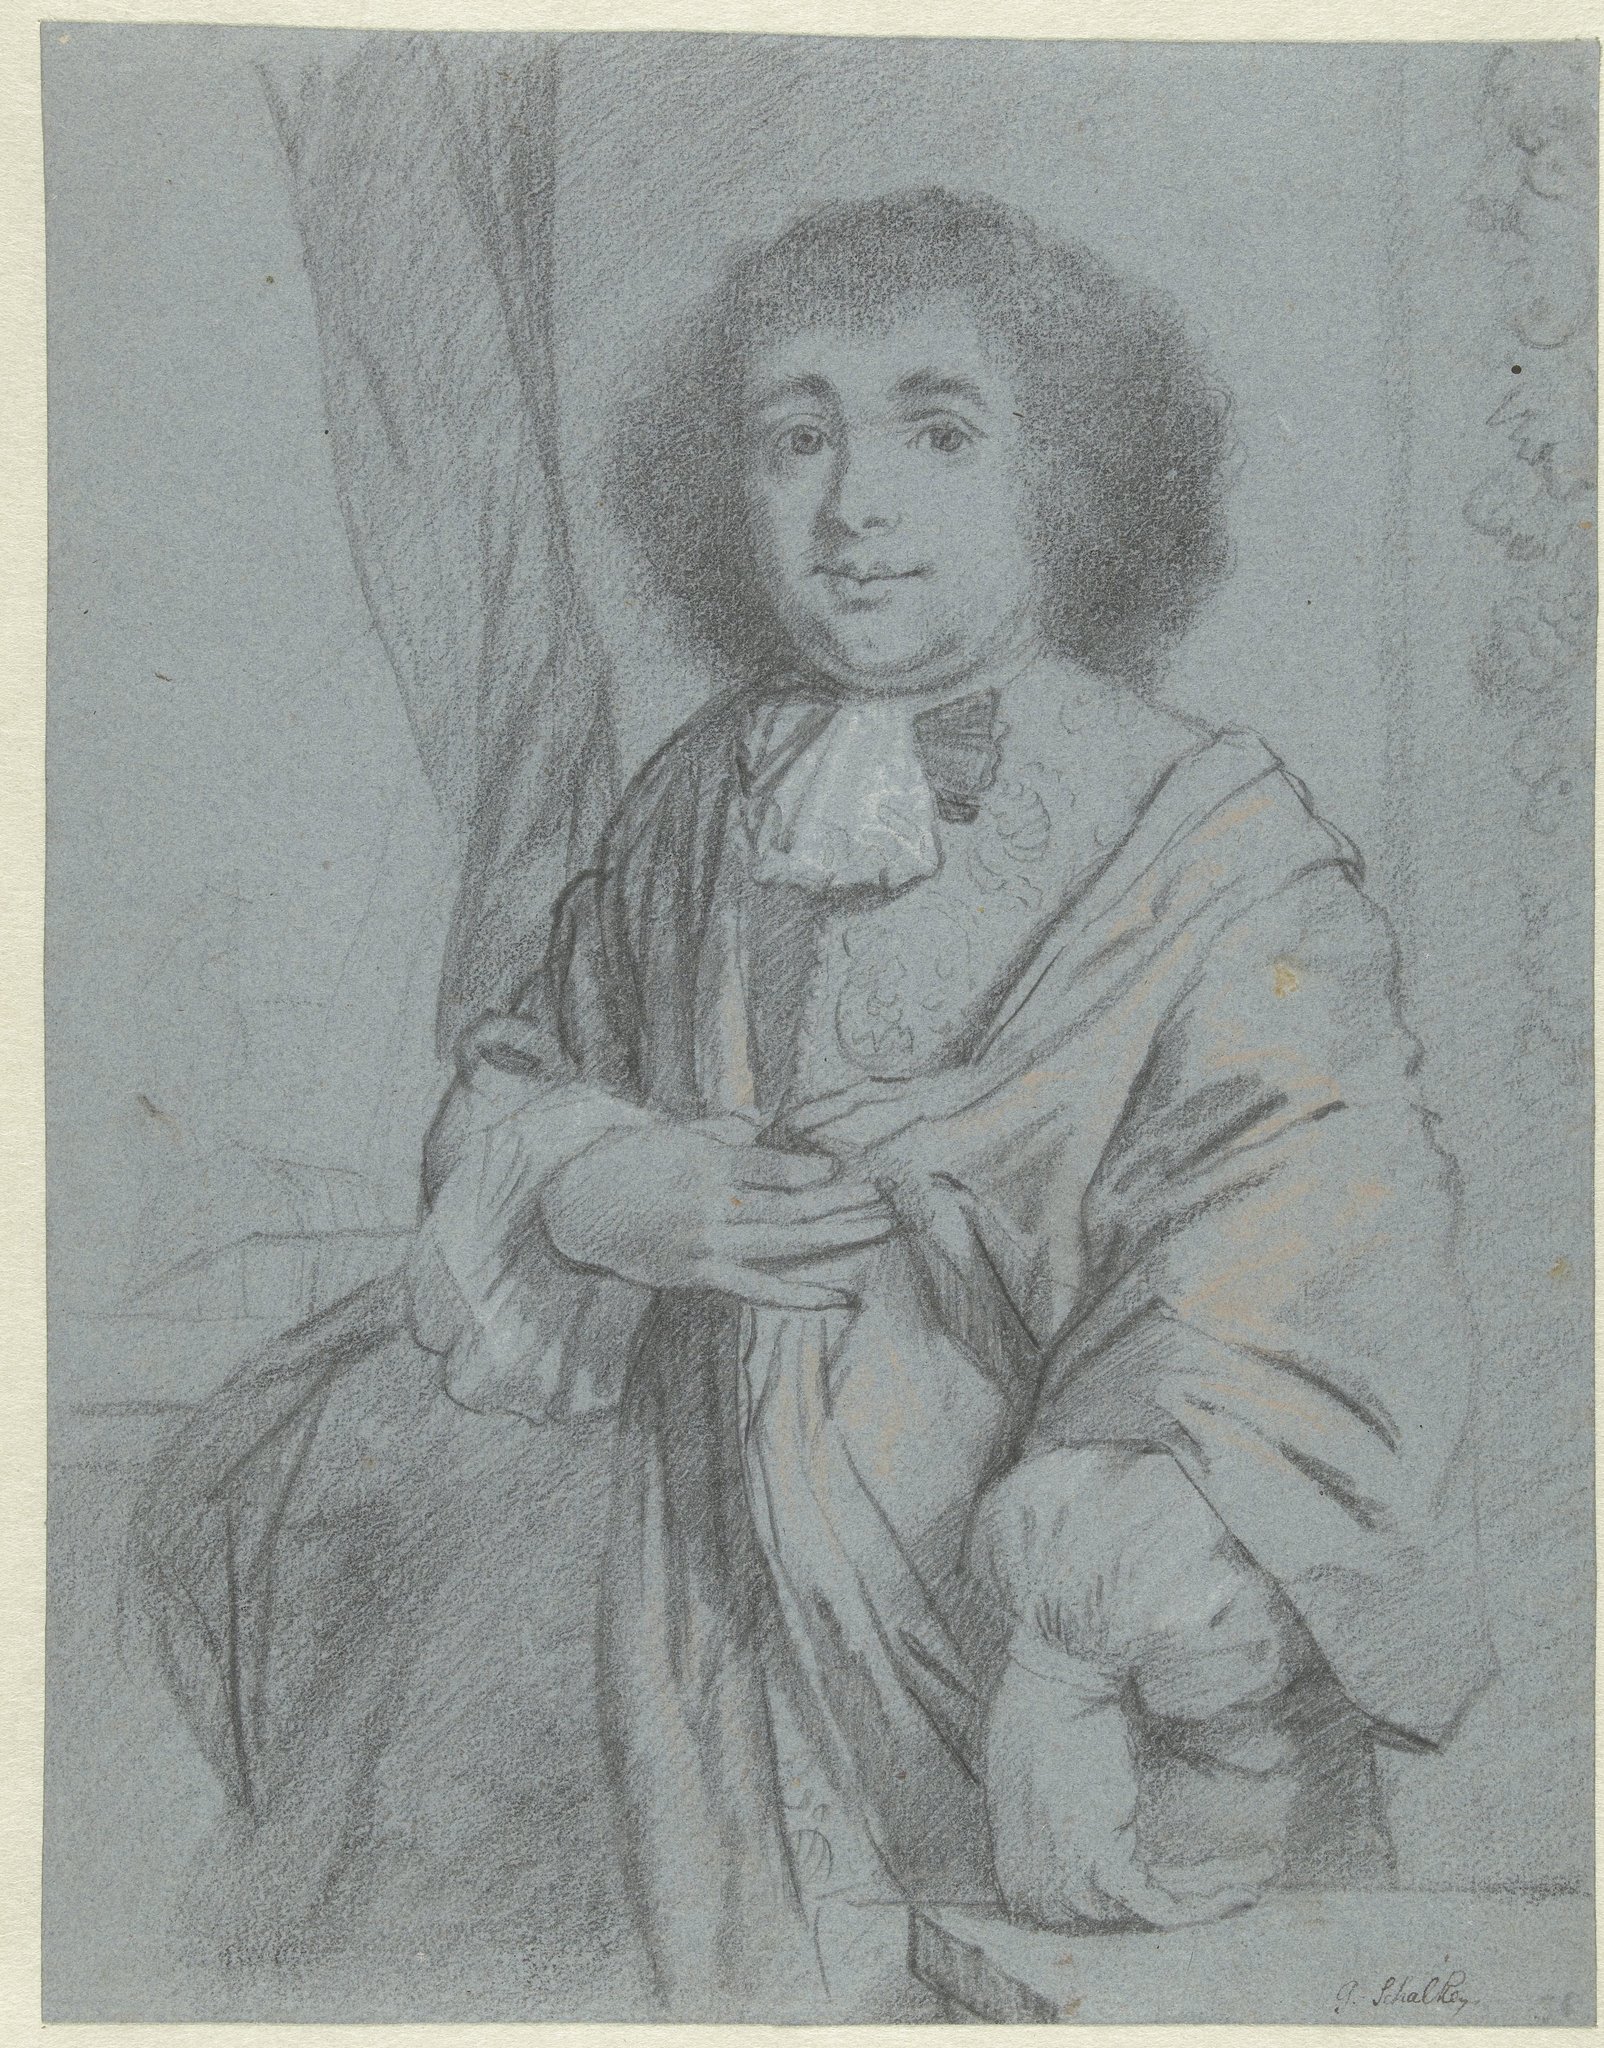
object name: drawing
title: Kunstboek of Studiealbum van Caspar Netscher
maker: godfried schalcken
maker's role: draughtsman, painter, print maker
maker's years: 1643-1706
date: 1653-1706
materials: chalk, paper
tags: anonymous historical person portrayed alone, male sex; man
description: Afkomstig uit een tekeningenalbum met onder andere figuur- en handstudies van of naar Caspar en Constantijn Netscher (BI-1894-3720). Tekening bevond zich oorspronkelijk op f. 39.